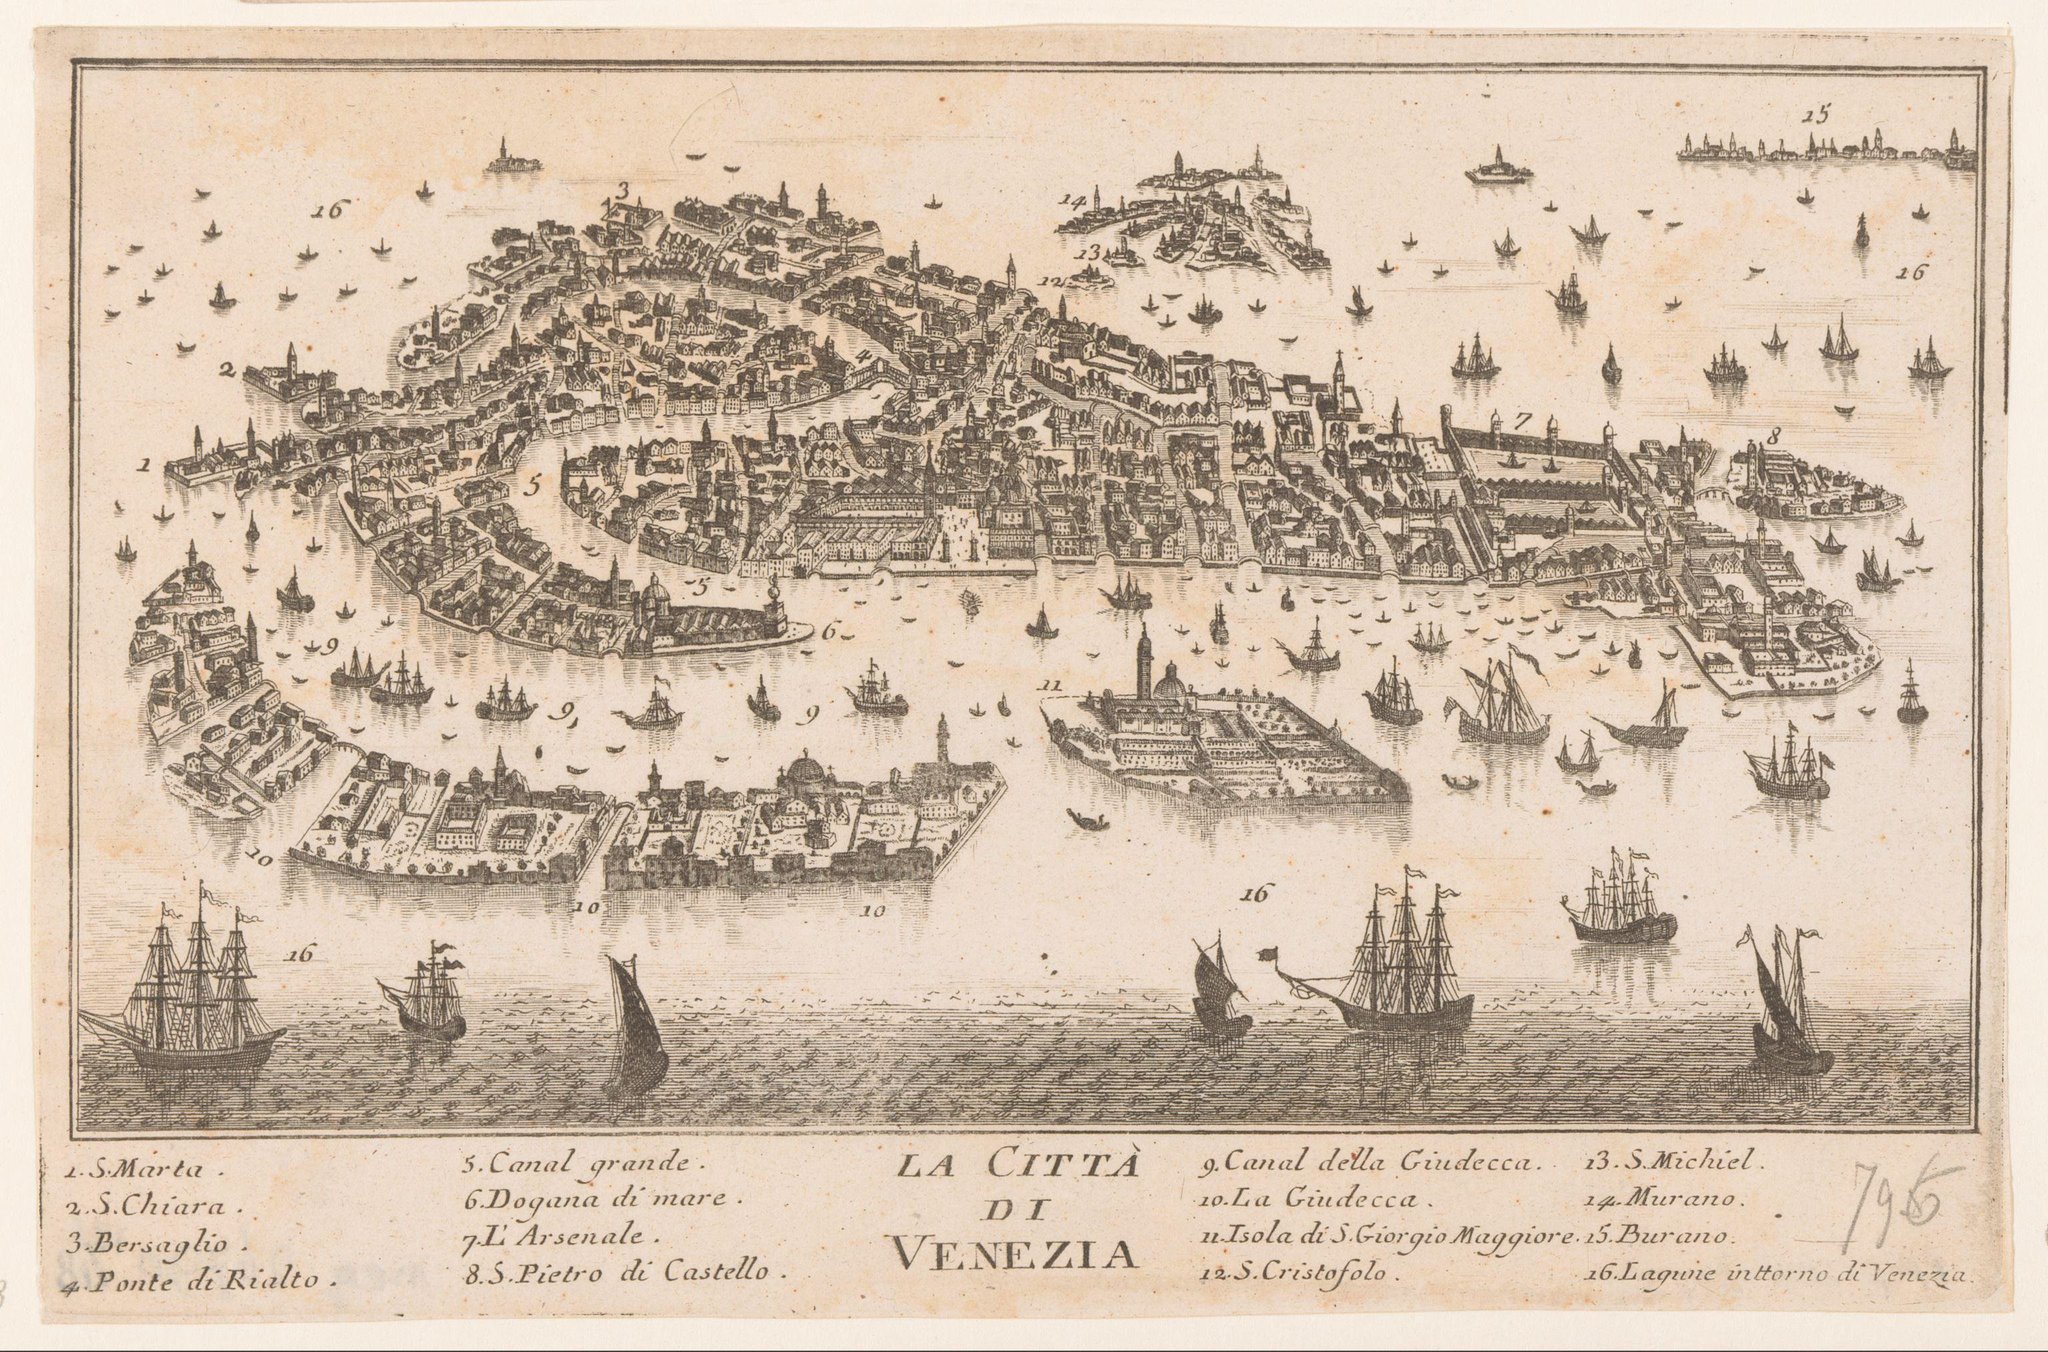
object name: area plan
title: Gezicht op Venetië in vogelvluchtperspectief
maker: Anonymous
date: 1650-1700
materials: paper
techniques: etching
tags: harbour, city-view, and landscape with man-made constructions, maps of cities, venice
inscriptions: collector's mark: Lugt 2228